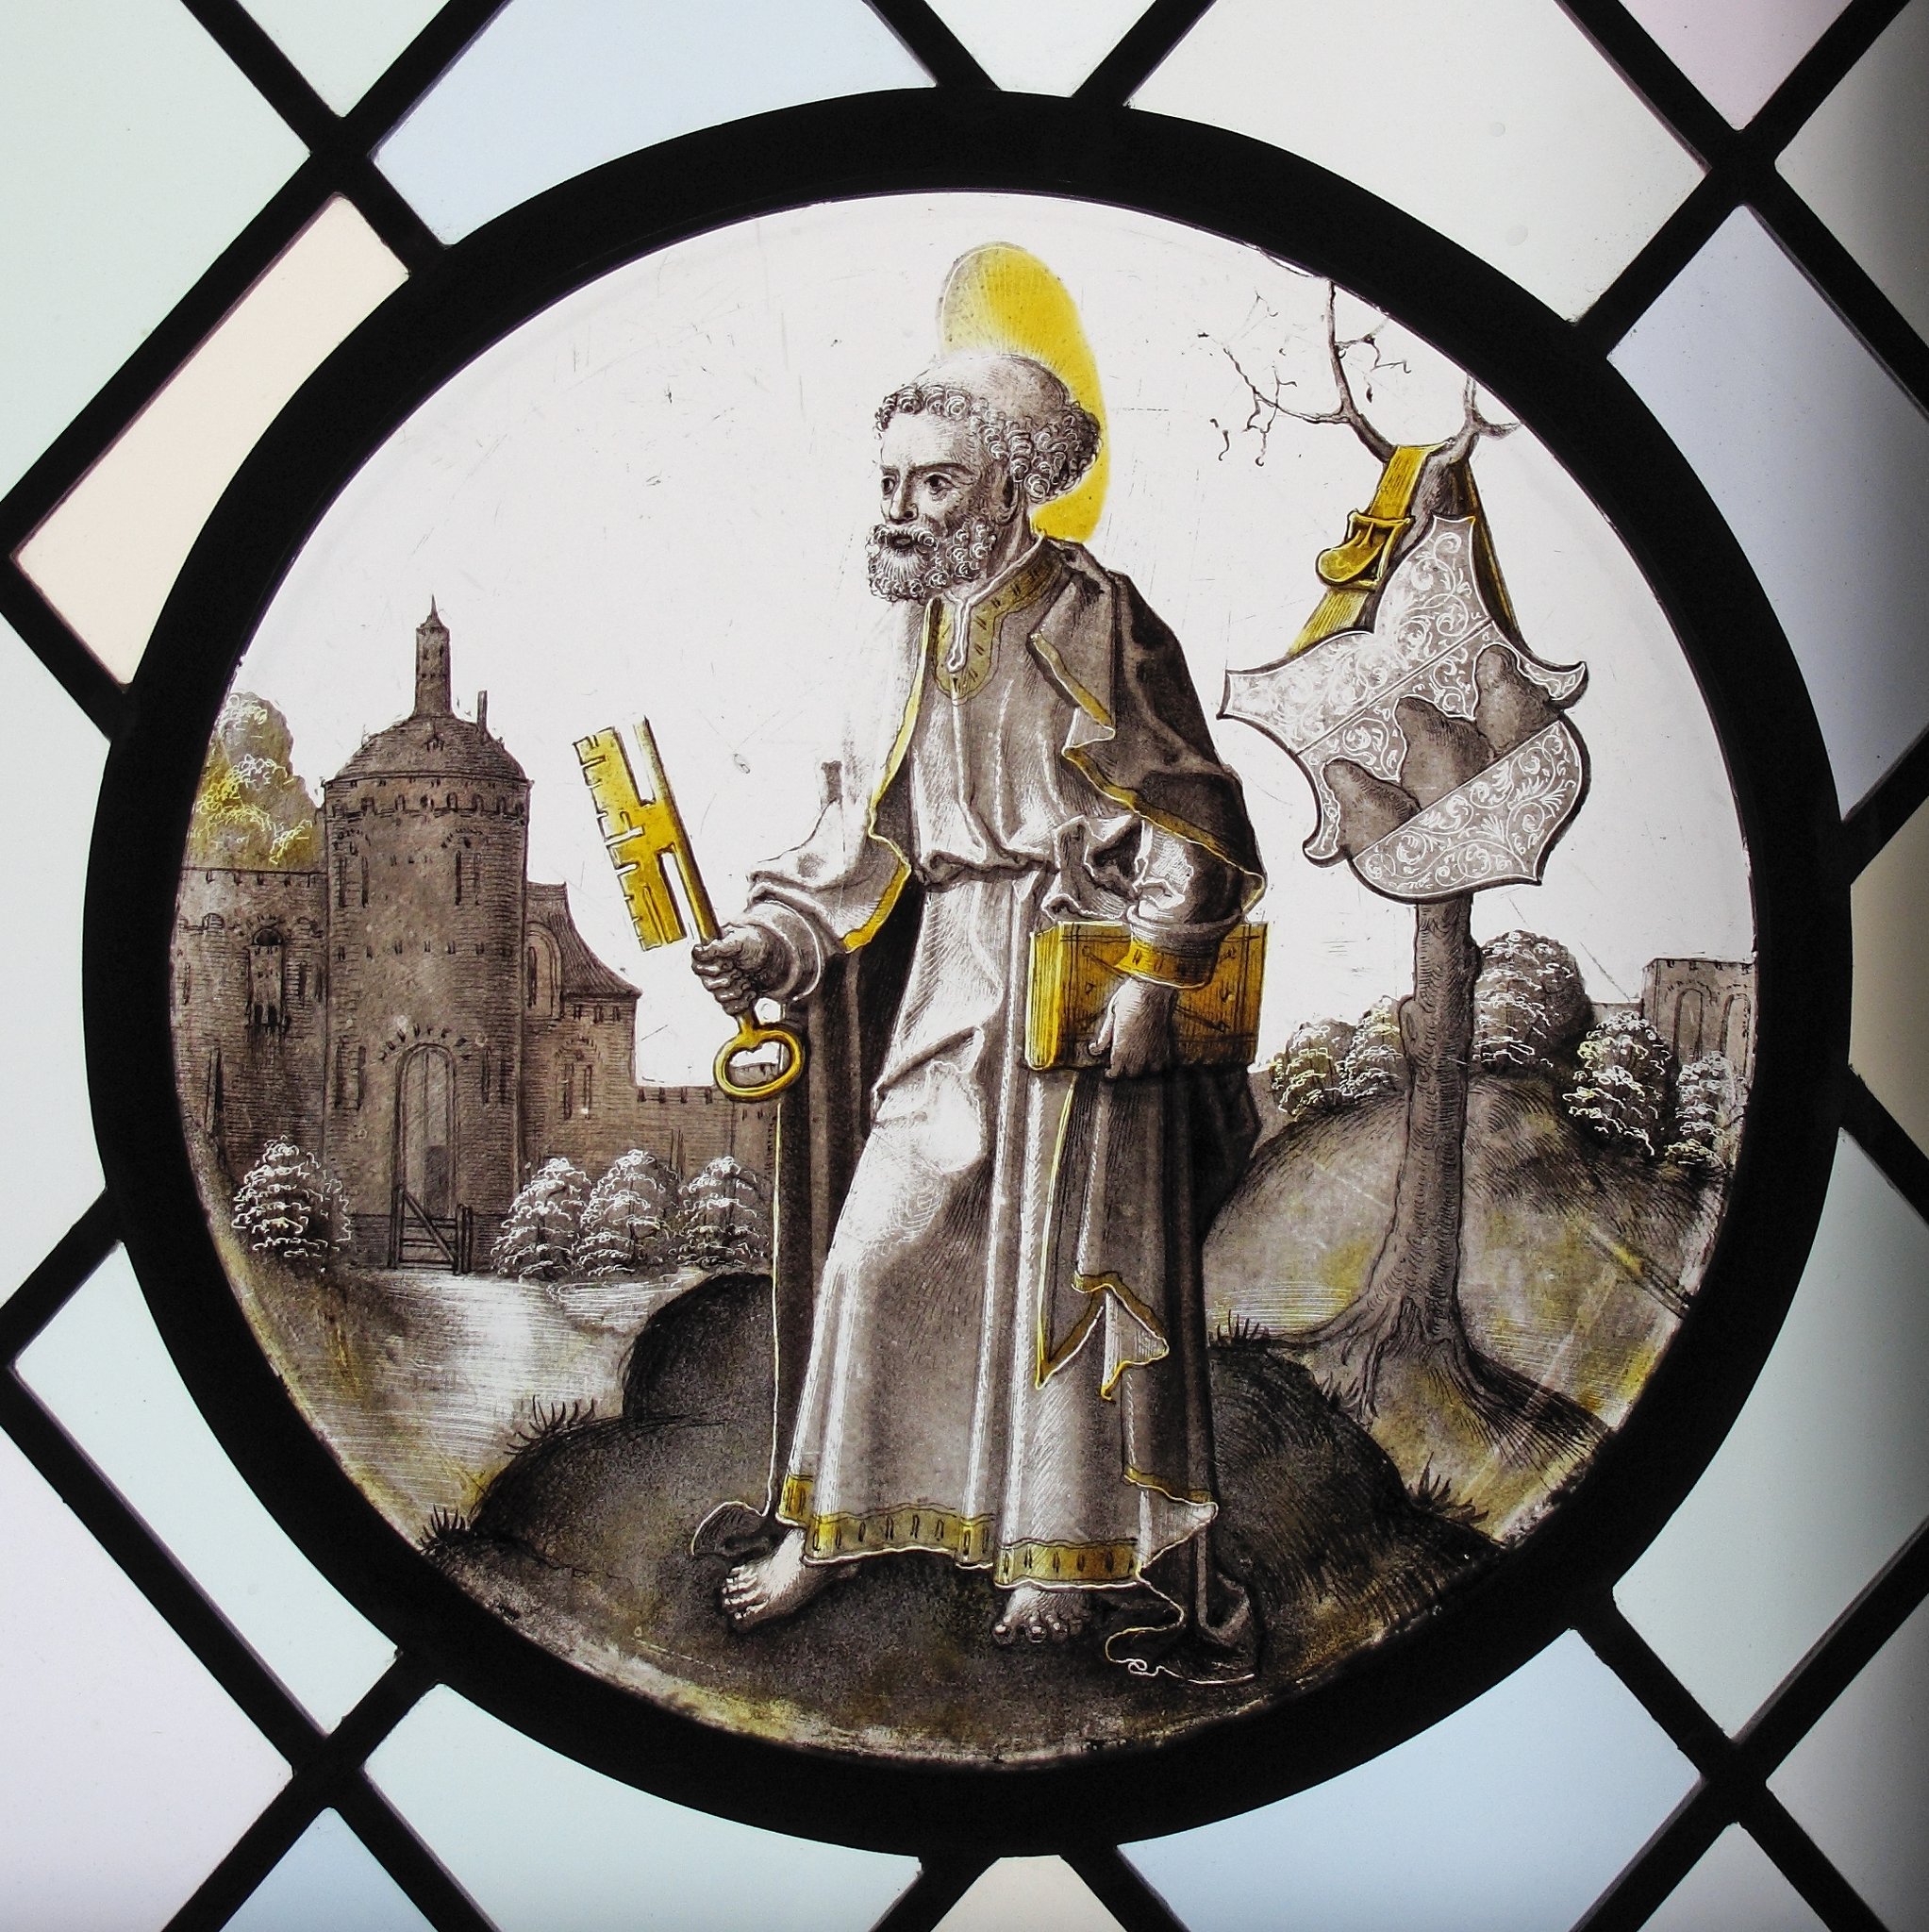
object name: roundel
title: Roundel with Saint Peter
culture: south netherlandish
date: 1520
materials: glass, paint, pigment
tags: saint peter,coat of arms,keys